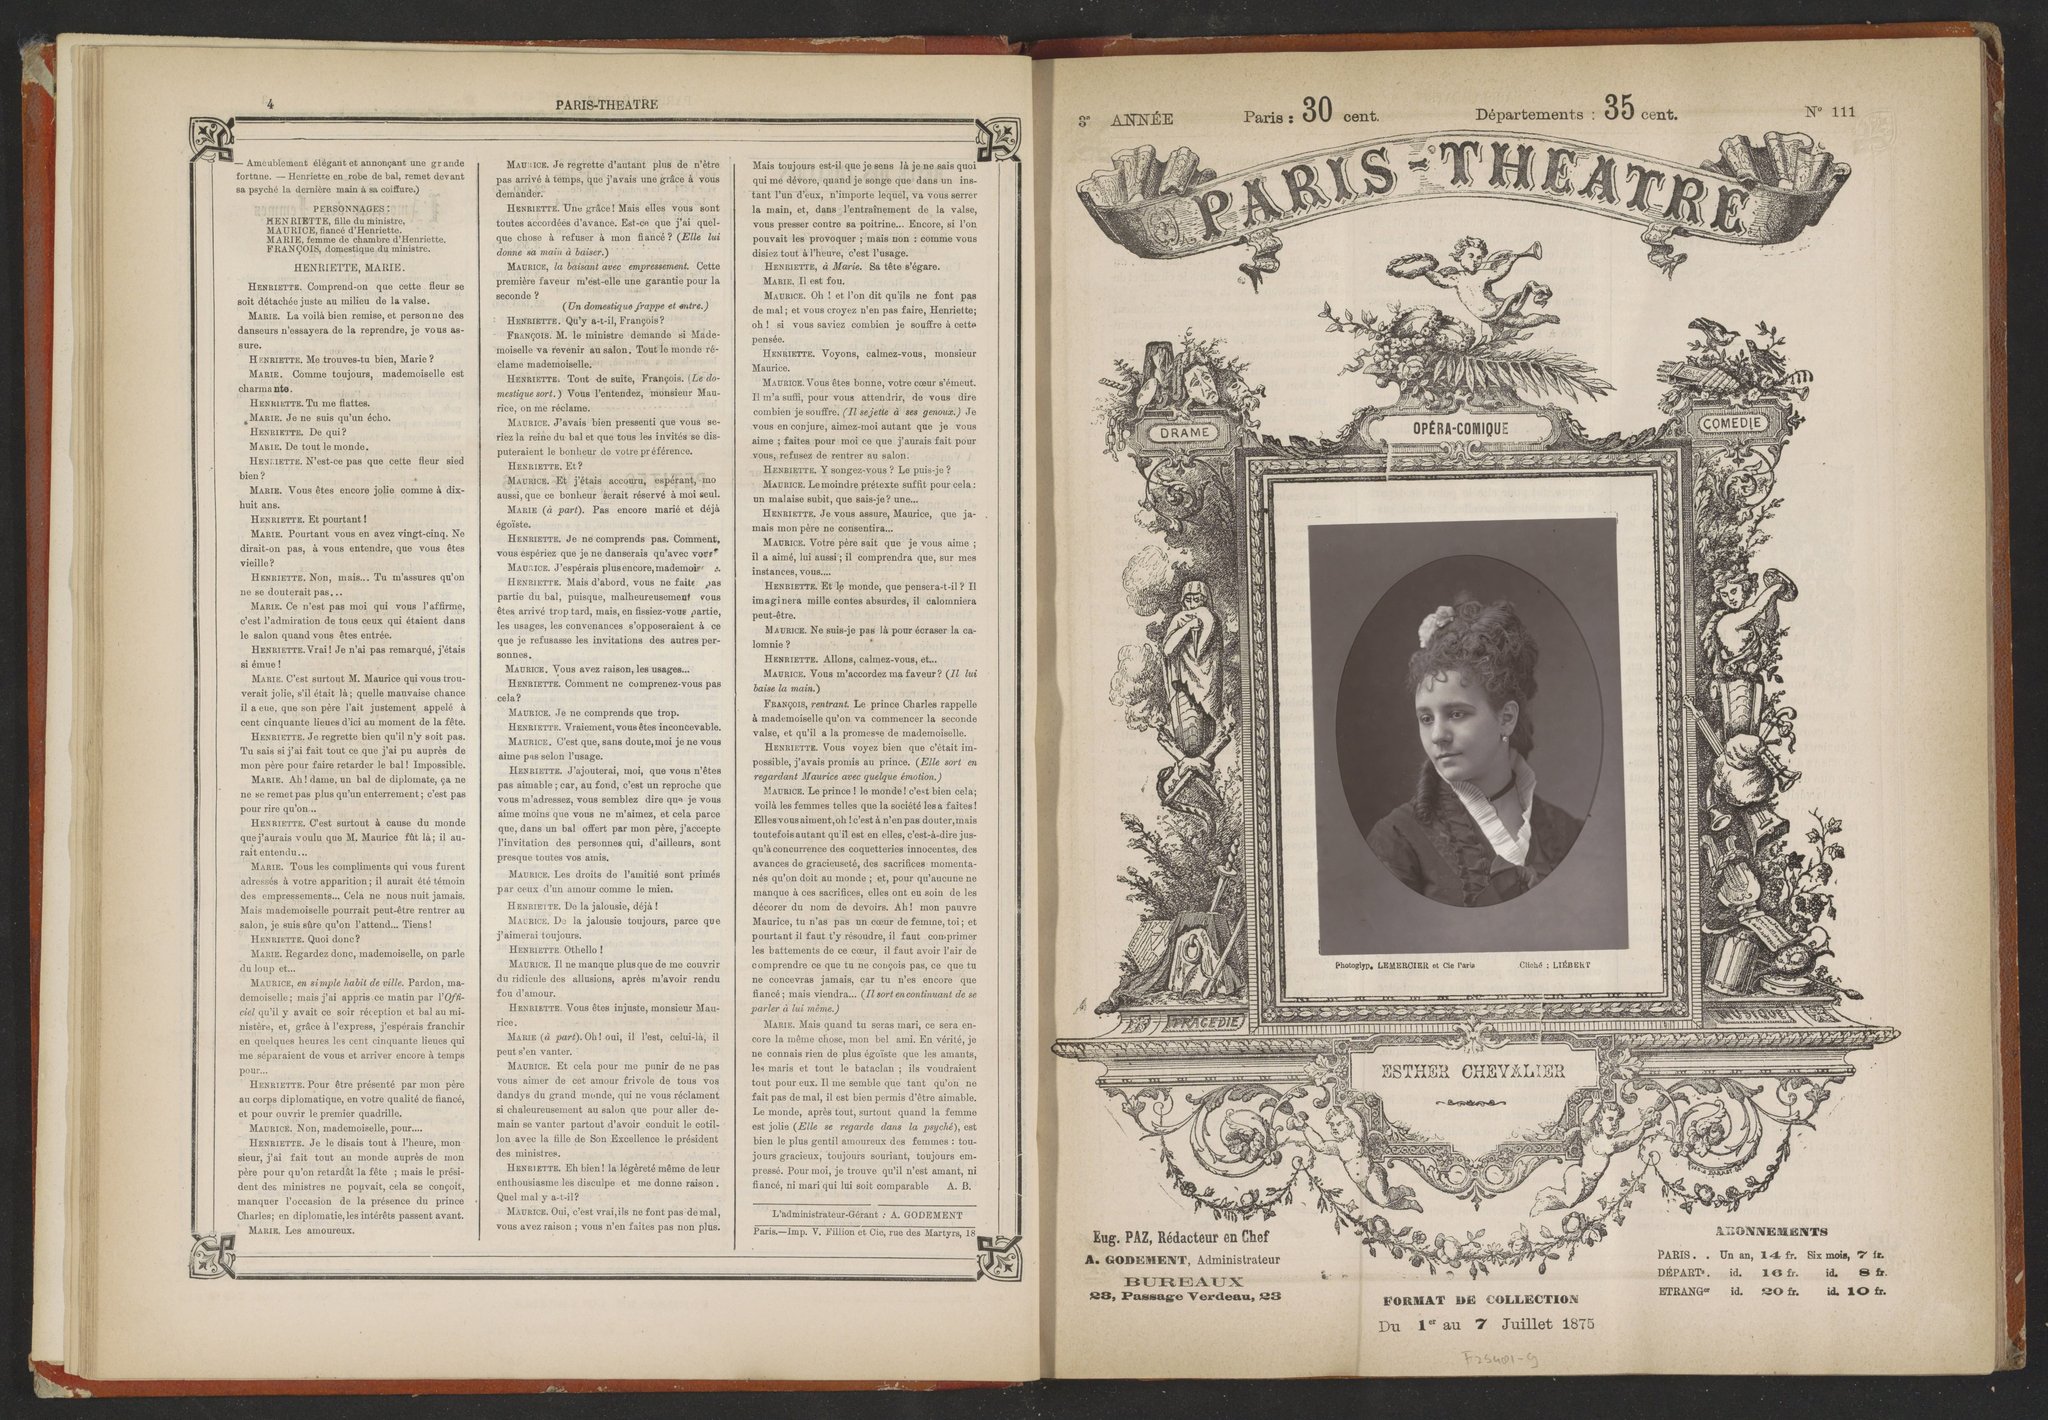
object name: page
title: Portret van Esther Chevalier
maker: alphonse-justin liébert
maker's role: fotograaf, marinier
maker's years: 1827-1914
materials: paper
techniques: woodburytype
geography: paris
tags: portrait of opera-singer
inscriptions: inscription: ‘Du 1er au 7 Juillet 1875’, number: ‘No 111’